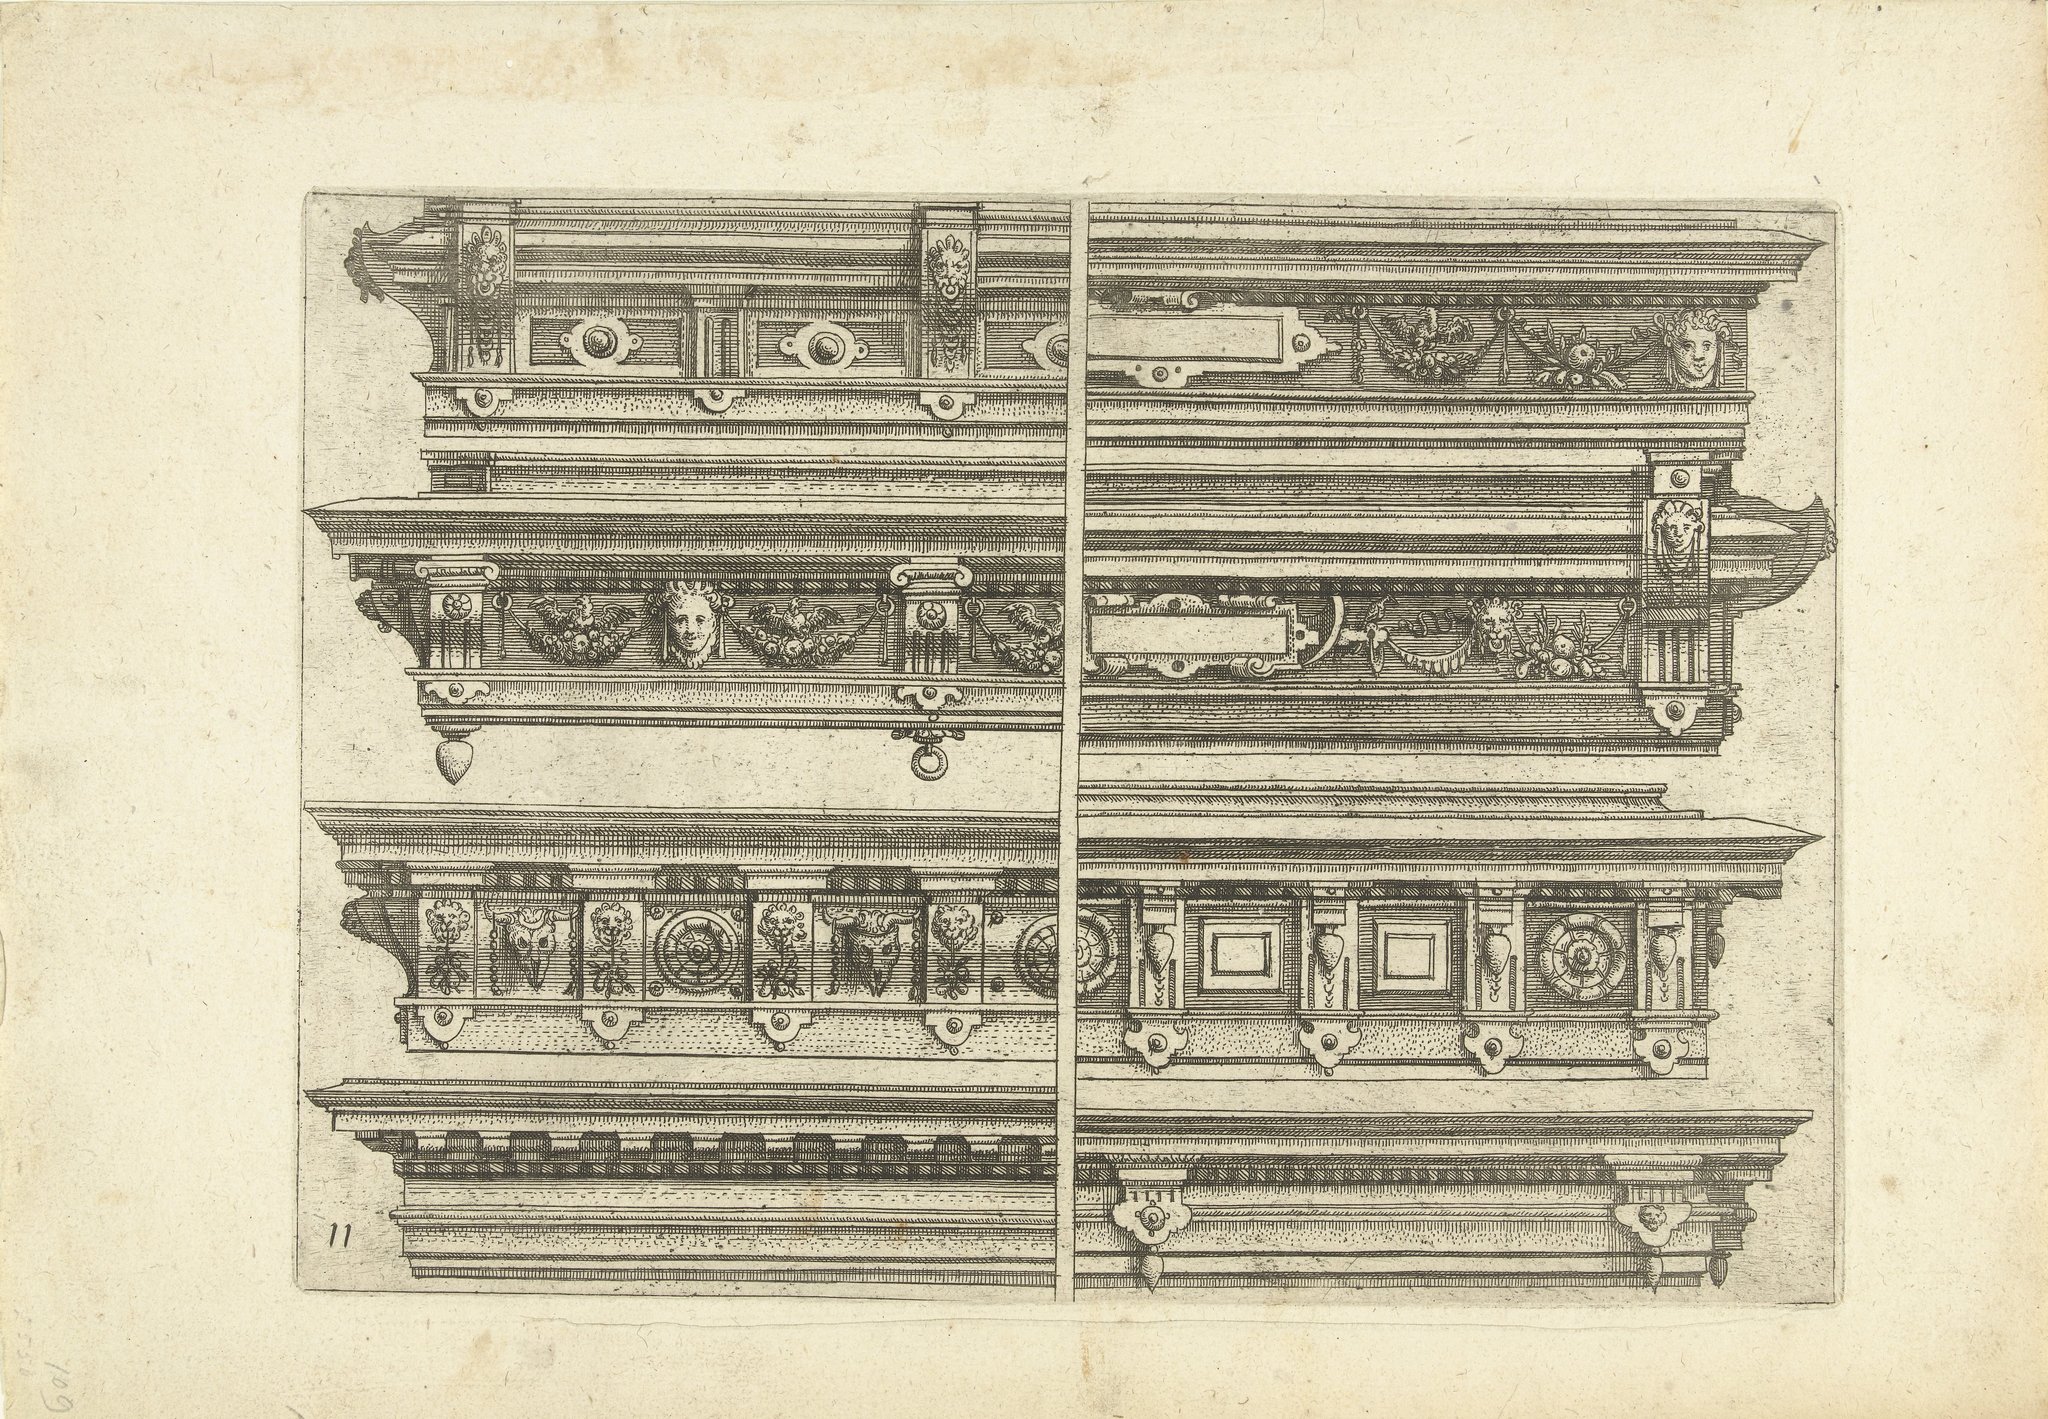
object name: ornament print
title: Differents pourtraicts de menuiseri (...)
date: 1583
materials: paper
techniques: etching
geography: netherlands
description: Drie van de hoofdgestellen met een fries, gedecoreerd met trigliefen en metopen. Blad 11 van 15 genummerde bladen + titelblad uit een serie van 16.